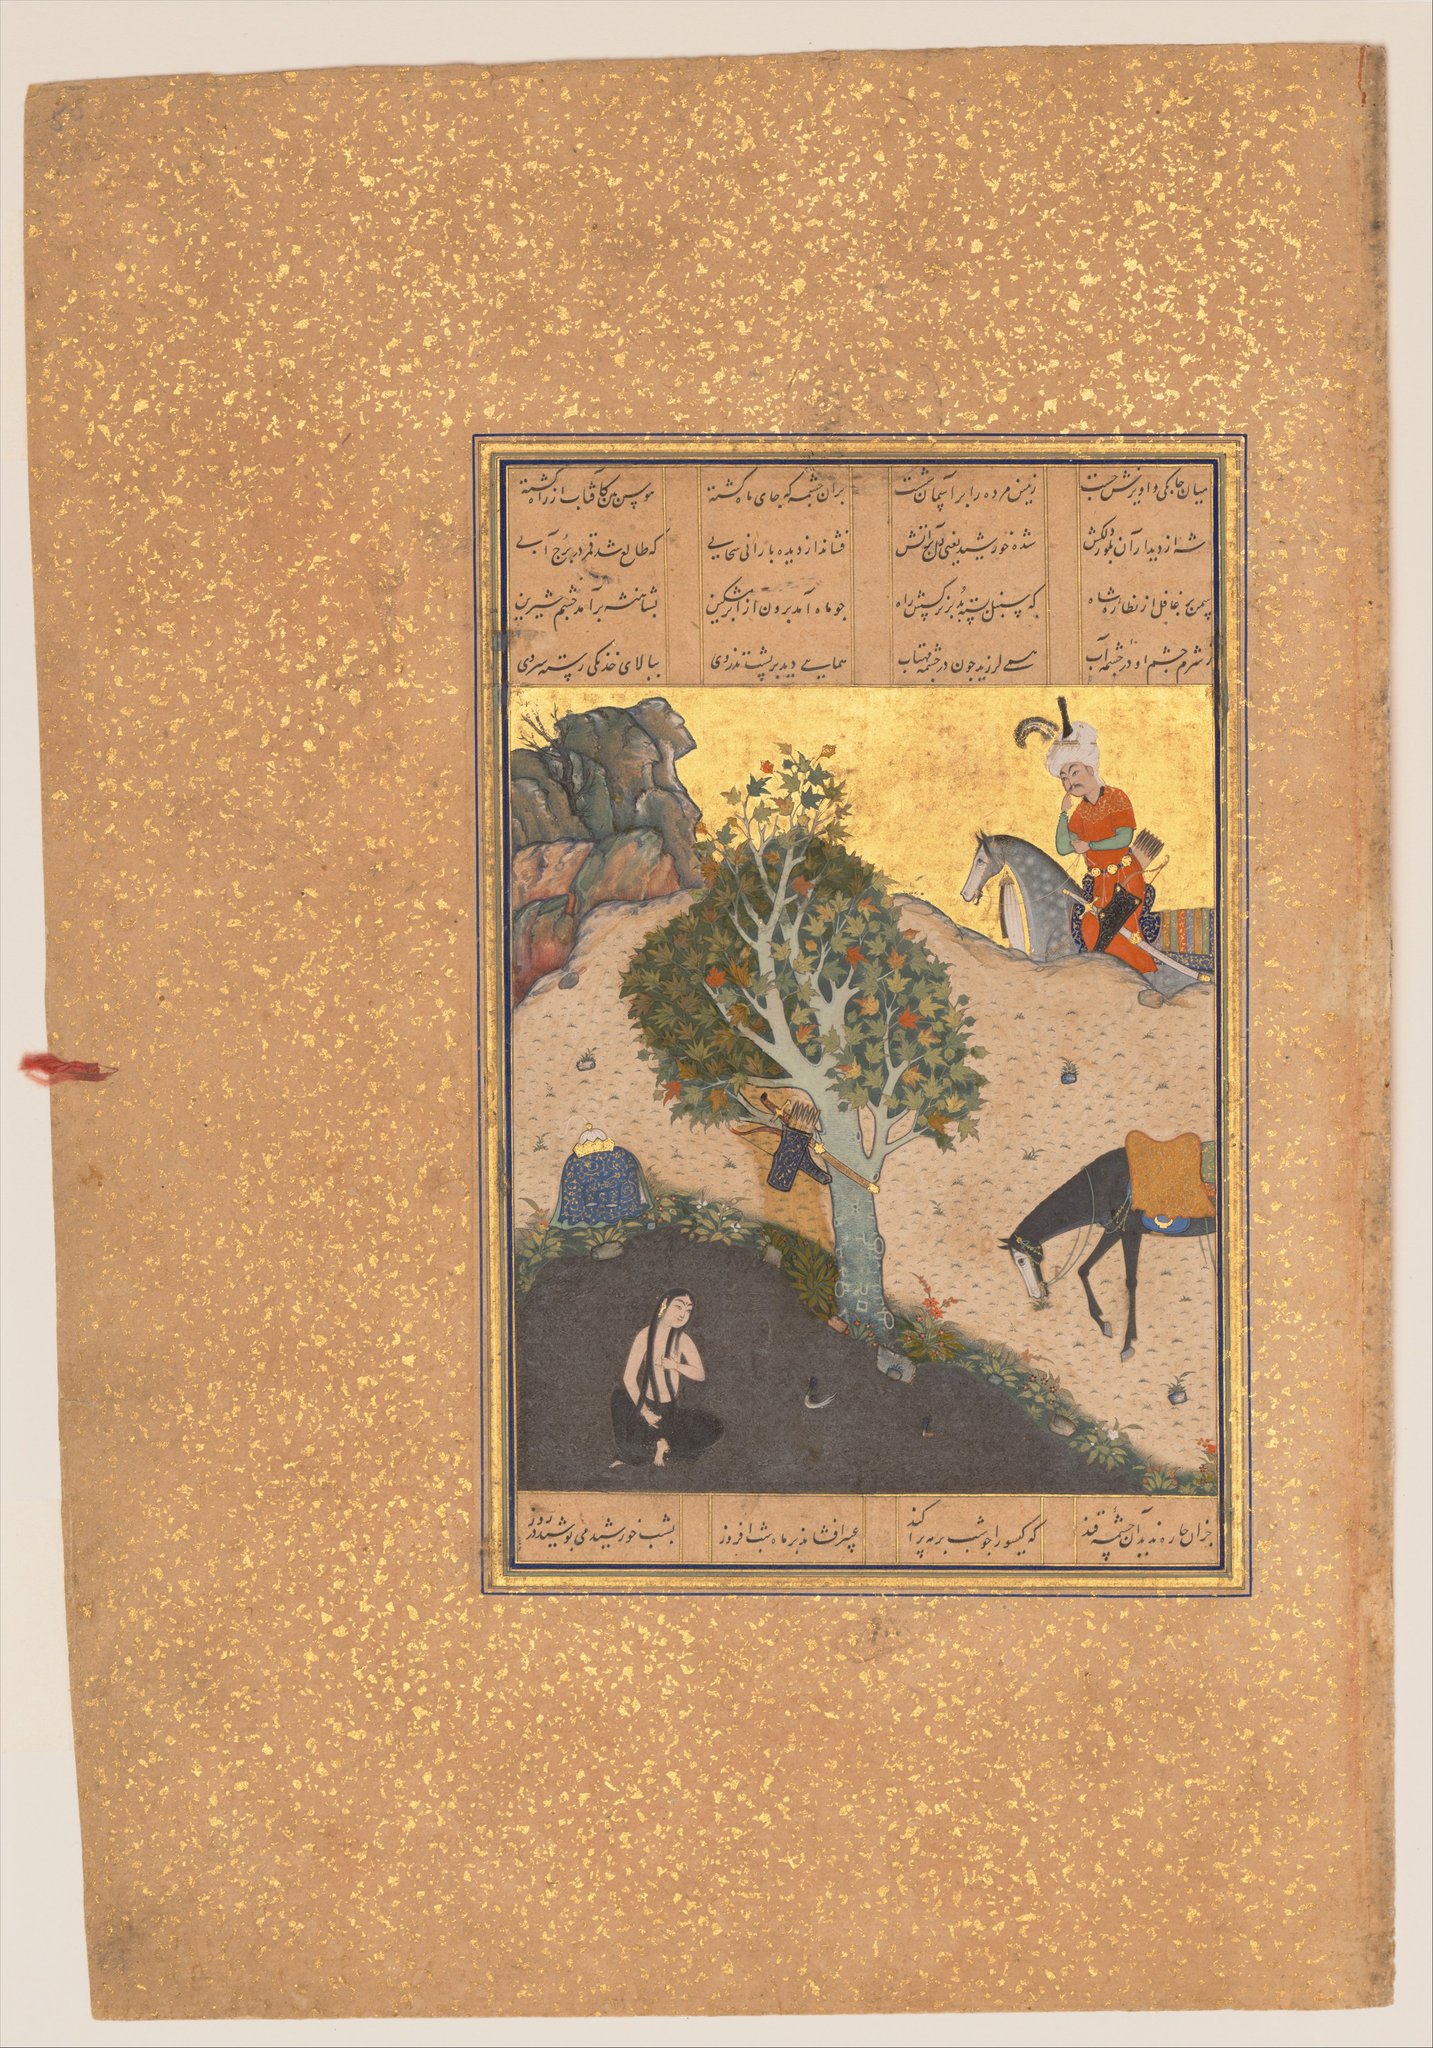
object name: folio from an illustrated manuscript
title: "Khusrau Catches Sight of Shirin Bathing", Folio 50 from a Khamsa (Quintet) of Nizami of Ganja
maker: nizami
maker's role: author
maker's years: 1141-1209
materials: gold, ink, paper, watercolor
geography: afghanistan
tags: kings,princesses,horses,bathing